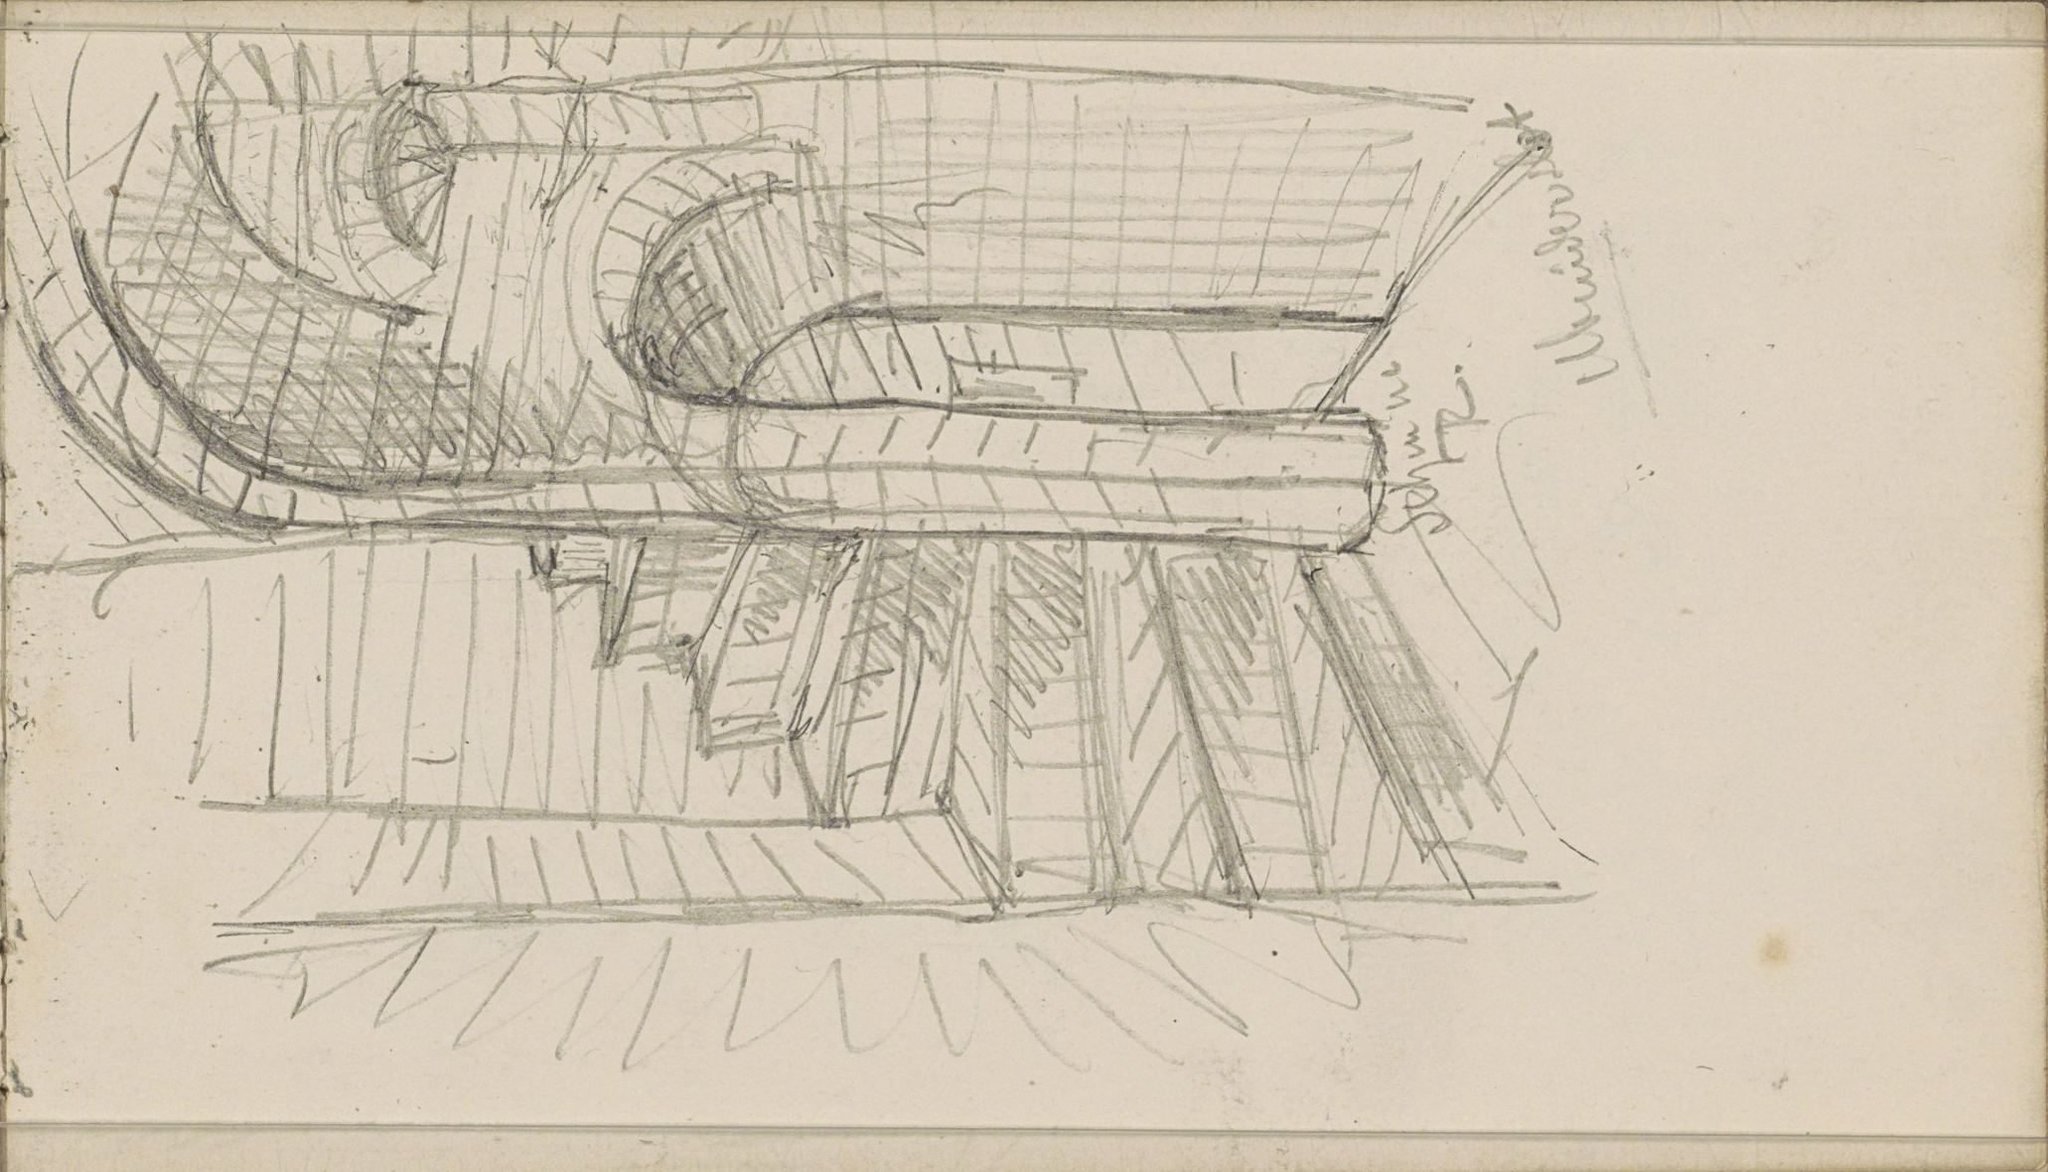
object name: sketchbook leaf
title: Wenteltrap in het Muiderslot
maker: isaac gosschalk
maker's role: draughtsman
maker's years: 1838-1907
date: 1866-1868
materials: paper, pencil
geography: muiden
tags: flight of steps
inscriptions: annotation: ‘schuine/ R/ Muiderslot’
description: Blad 64 recto uit een schetsboek met 67 bladen.